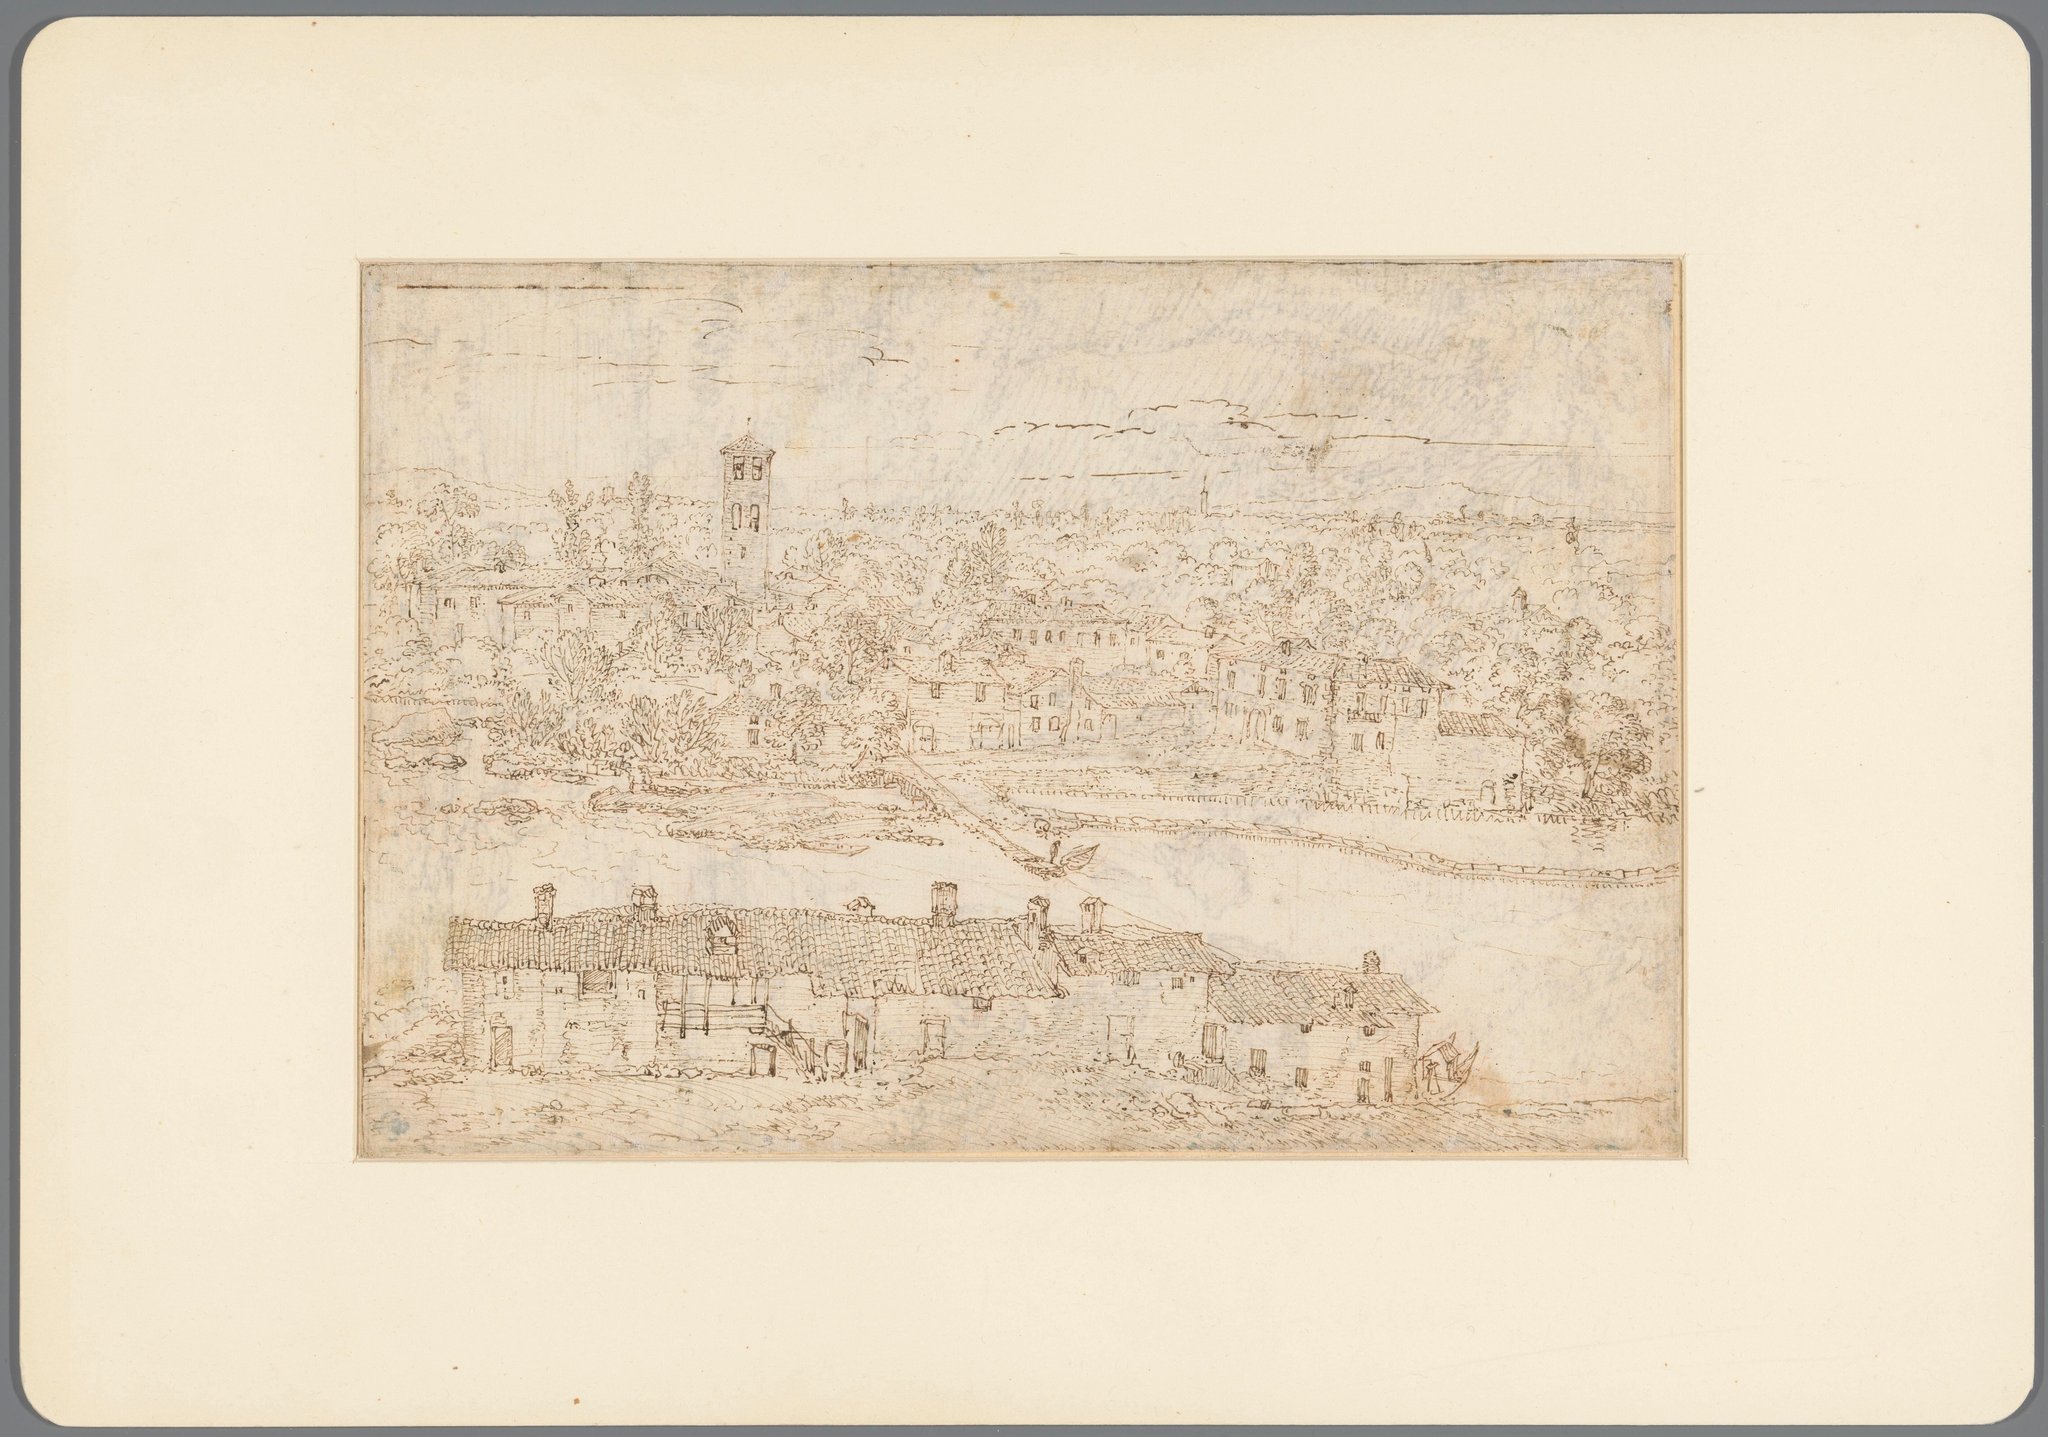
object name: drawing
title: Landschap met gezicht op dorp aan rivier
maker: gaspard dughet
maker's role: draughtsman, painter, print maker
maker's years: 1615-1675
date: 1625-1675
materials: ink, paper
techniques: pen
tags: prospect of village, silhouette of village, canals, waters (in village)